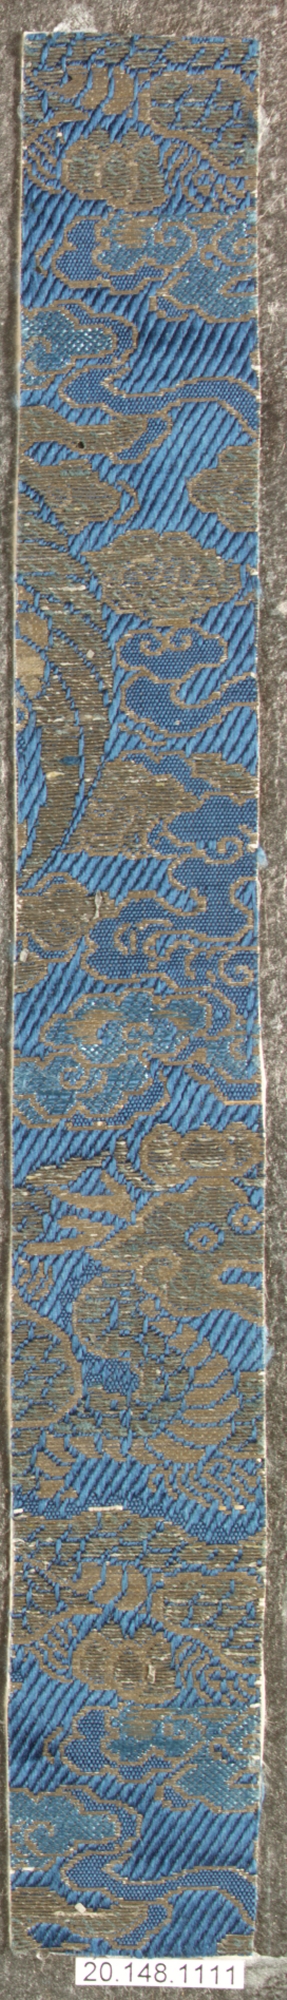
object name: piece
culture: japanese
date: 1701-1800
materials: silk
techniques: compound weave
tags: dragons